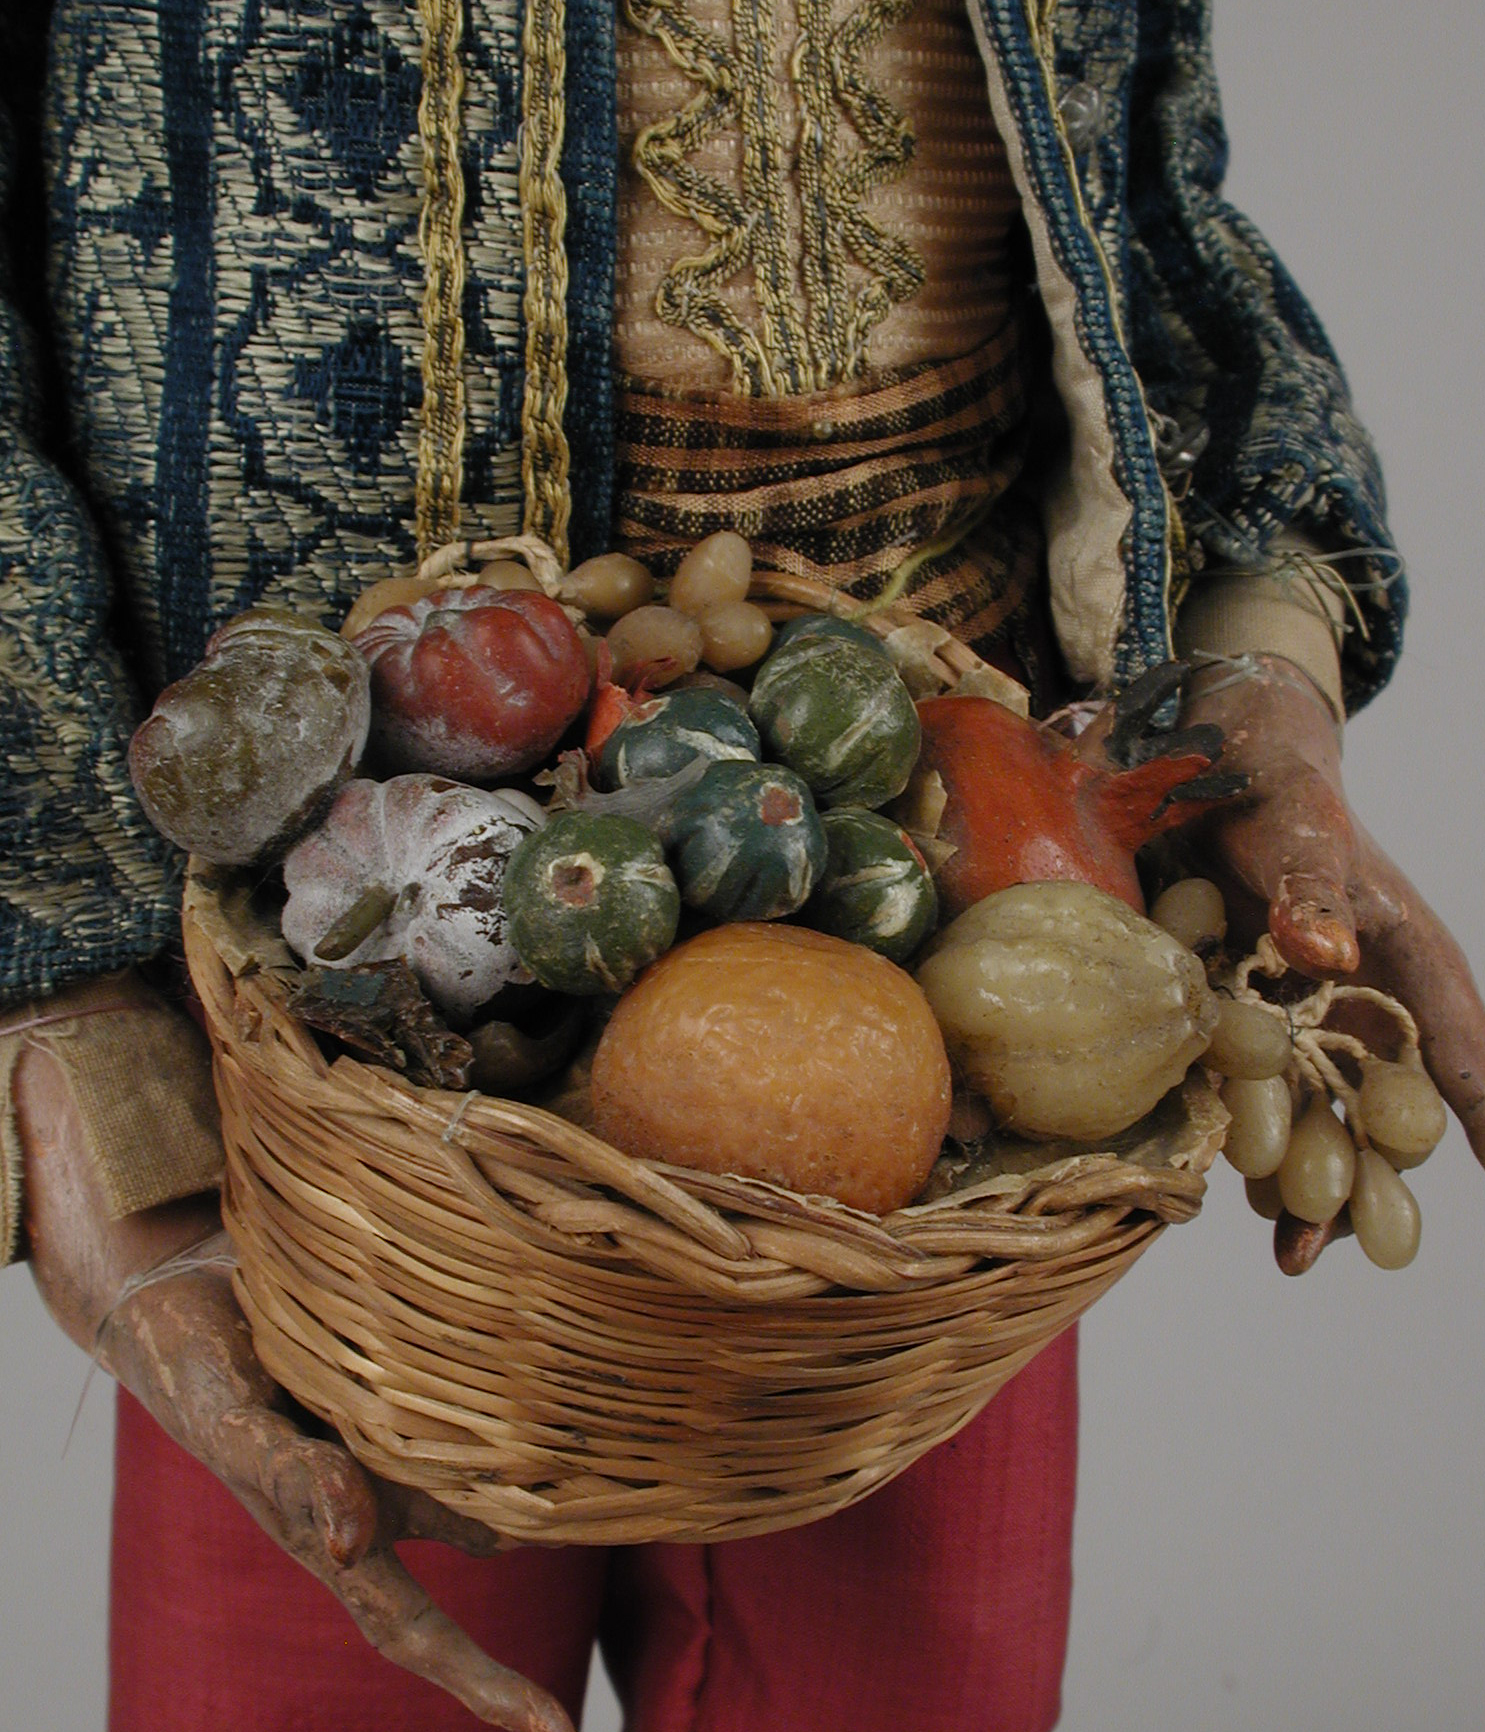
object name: crèche accessory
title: Basket of fruit and vegetables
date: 1701-1800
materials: wax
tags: fruit,vegetables,hands